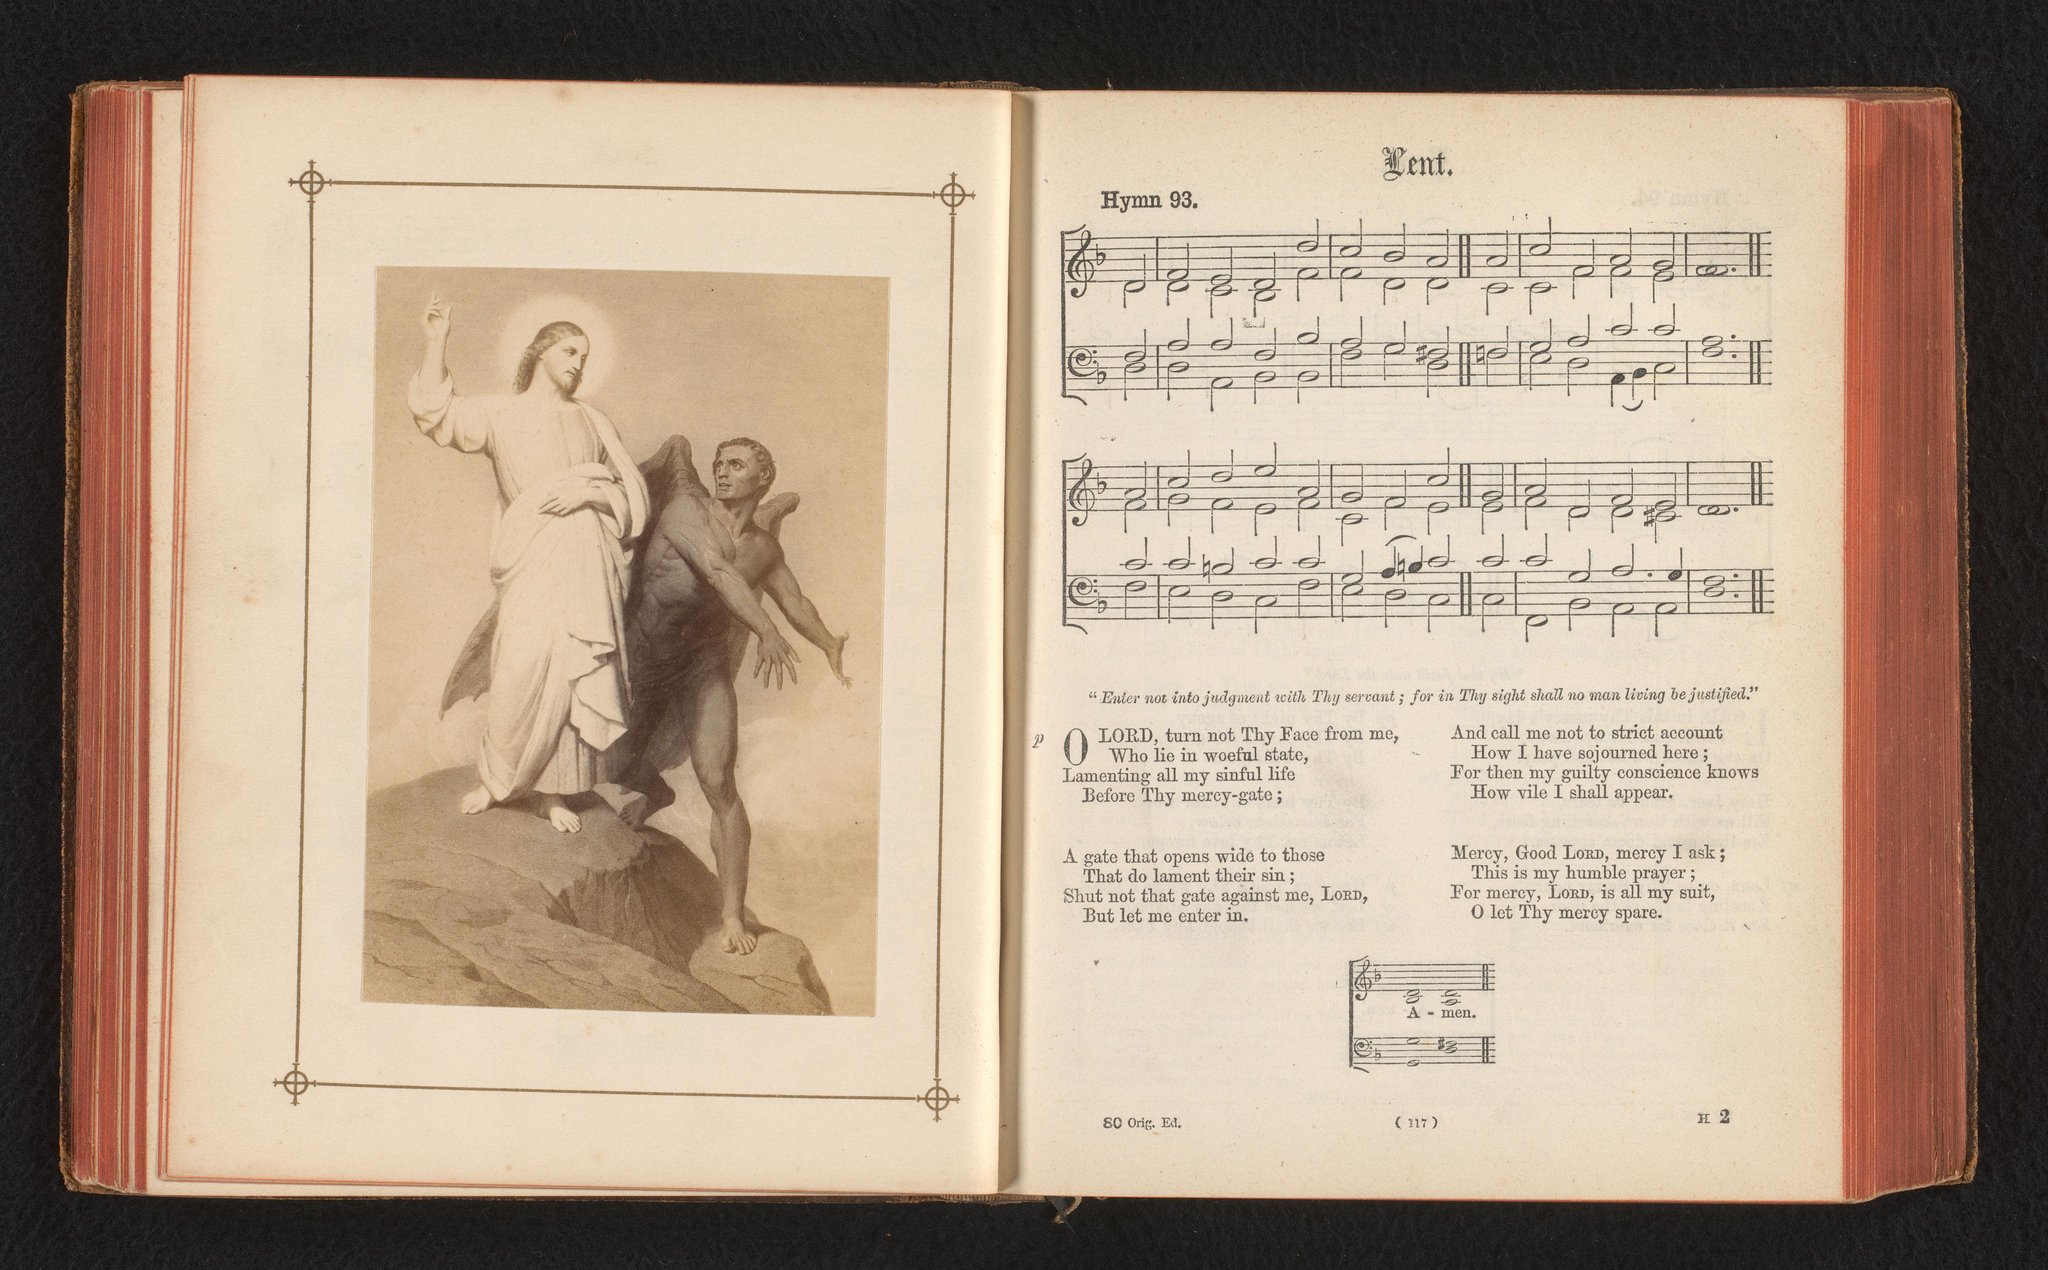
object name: reproduction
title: Fotoreproductie van een schilderij van Christus en de duivel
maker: Anonymous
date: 1866-1876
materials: paper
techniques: albumen print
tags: adult christ ~ devil(s) and demonic creatures, picture, painting